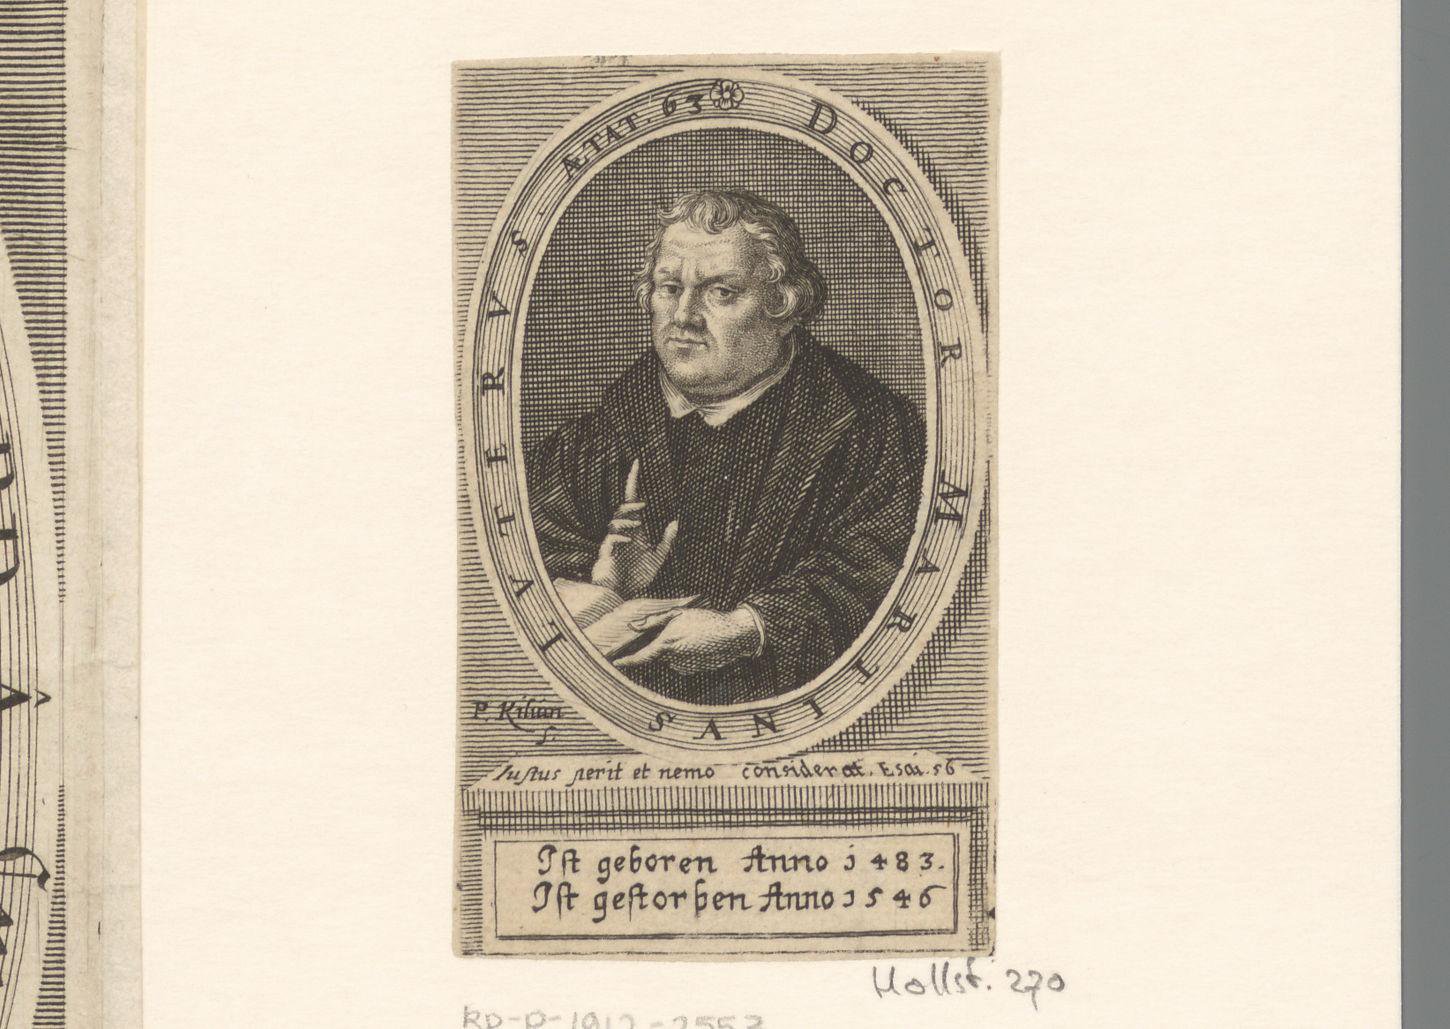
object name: print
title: Portret van Martin Luther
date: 1638-1693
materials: paper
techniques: engraving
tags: priest, martin luther, theologian, historical persons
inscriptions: collector's mark: Lugt 2228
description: Tekst in het Latijn en het Duits in de omlijsting en in de ondermarge.